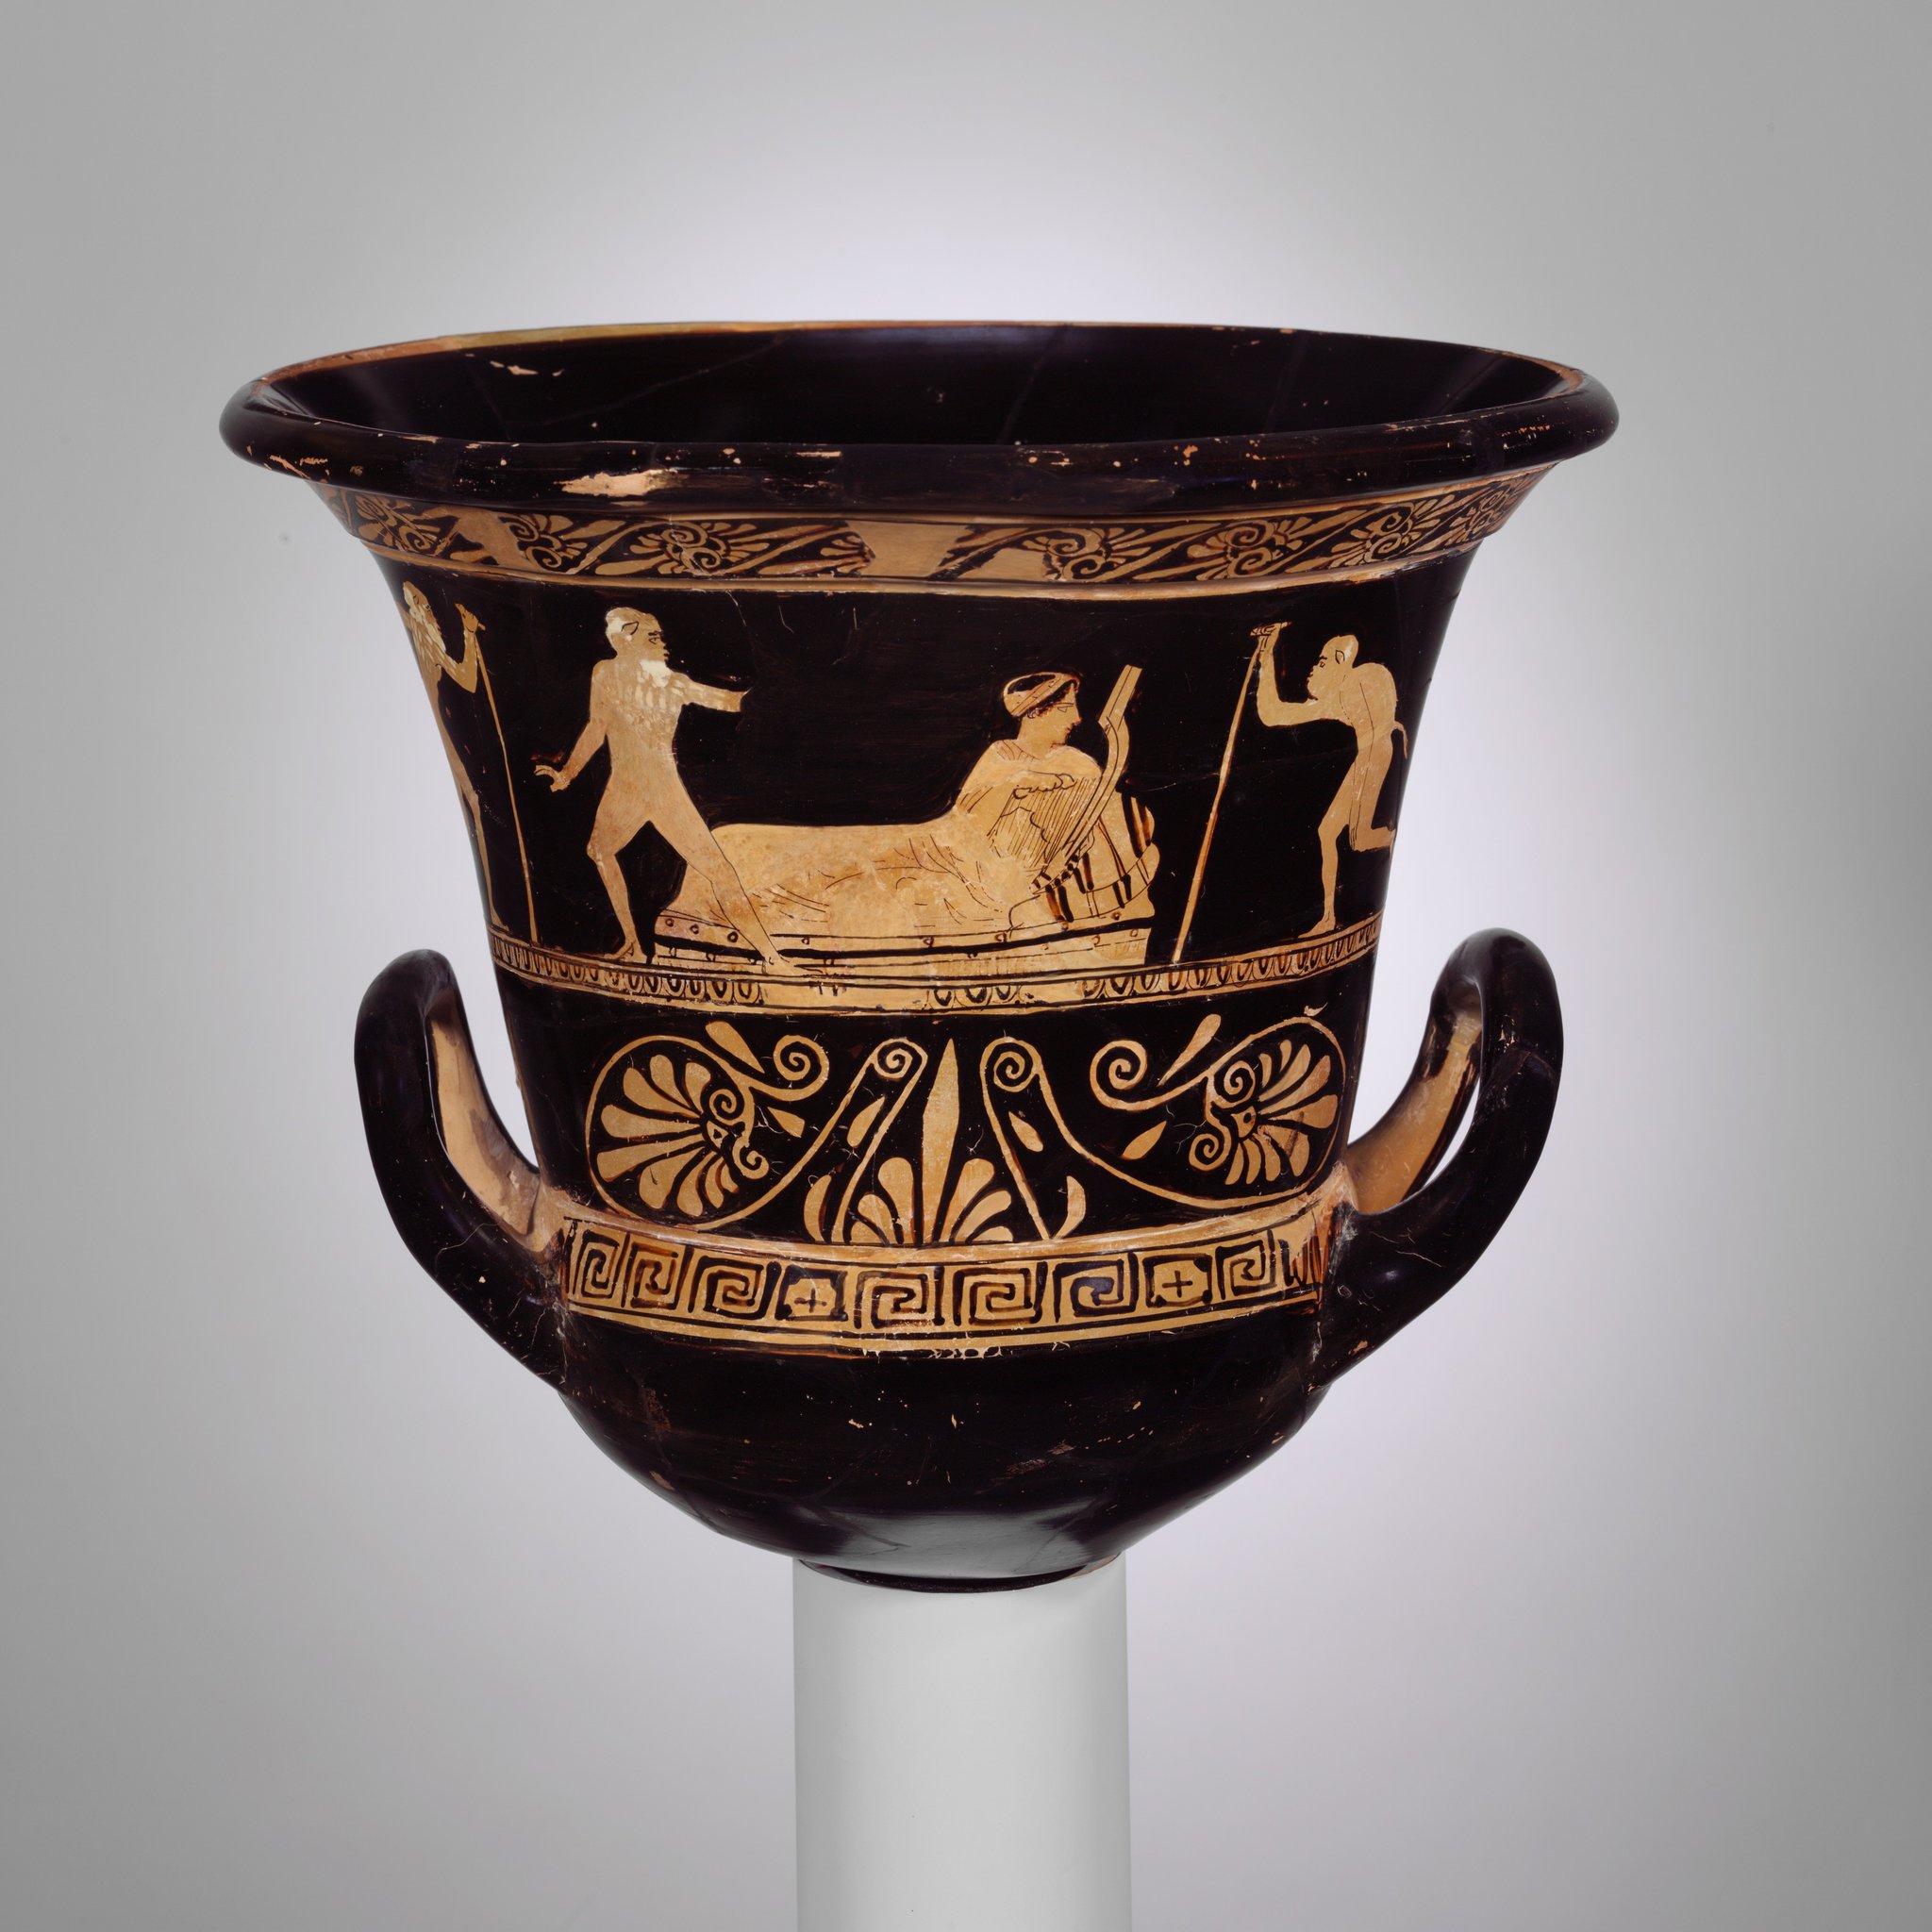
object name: calyx krater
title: Terracotta calyx-krater (bowl for mixing wine and water)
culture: greek, attic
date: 450-401 BCE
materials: terracotta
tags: dionysus,ariadne,maenads,satyrs